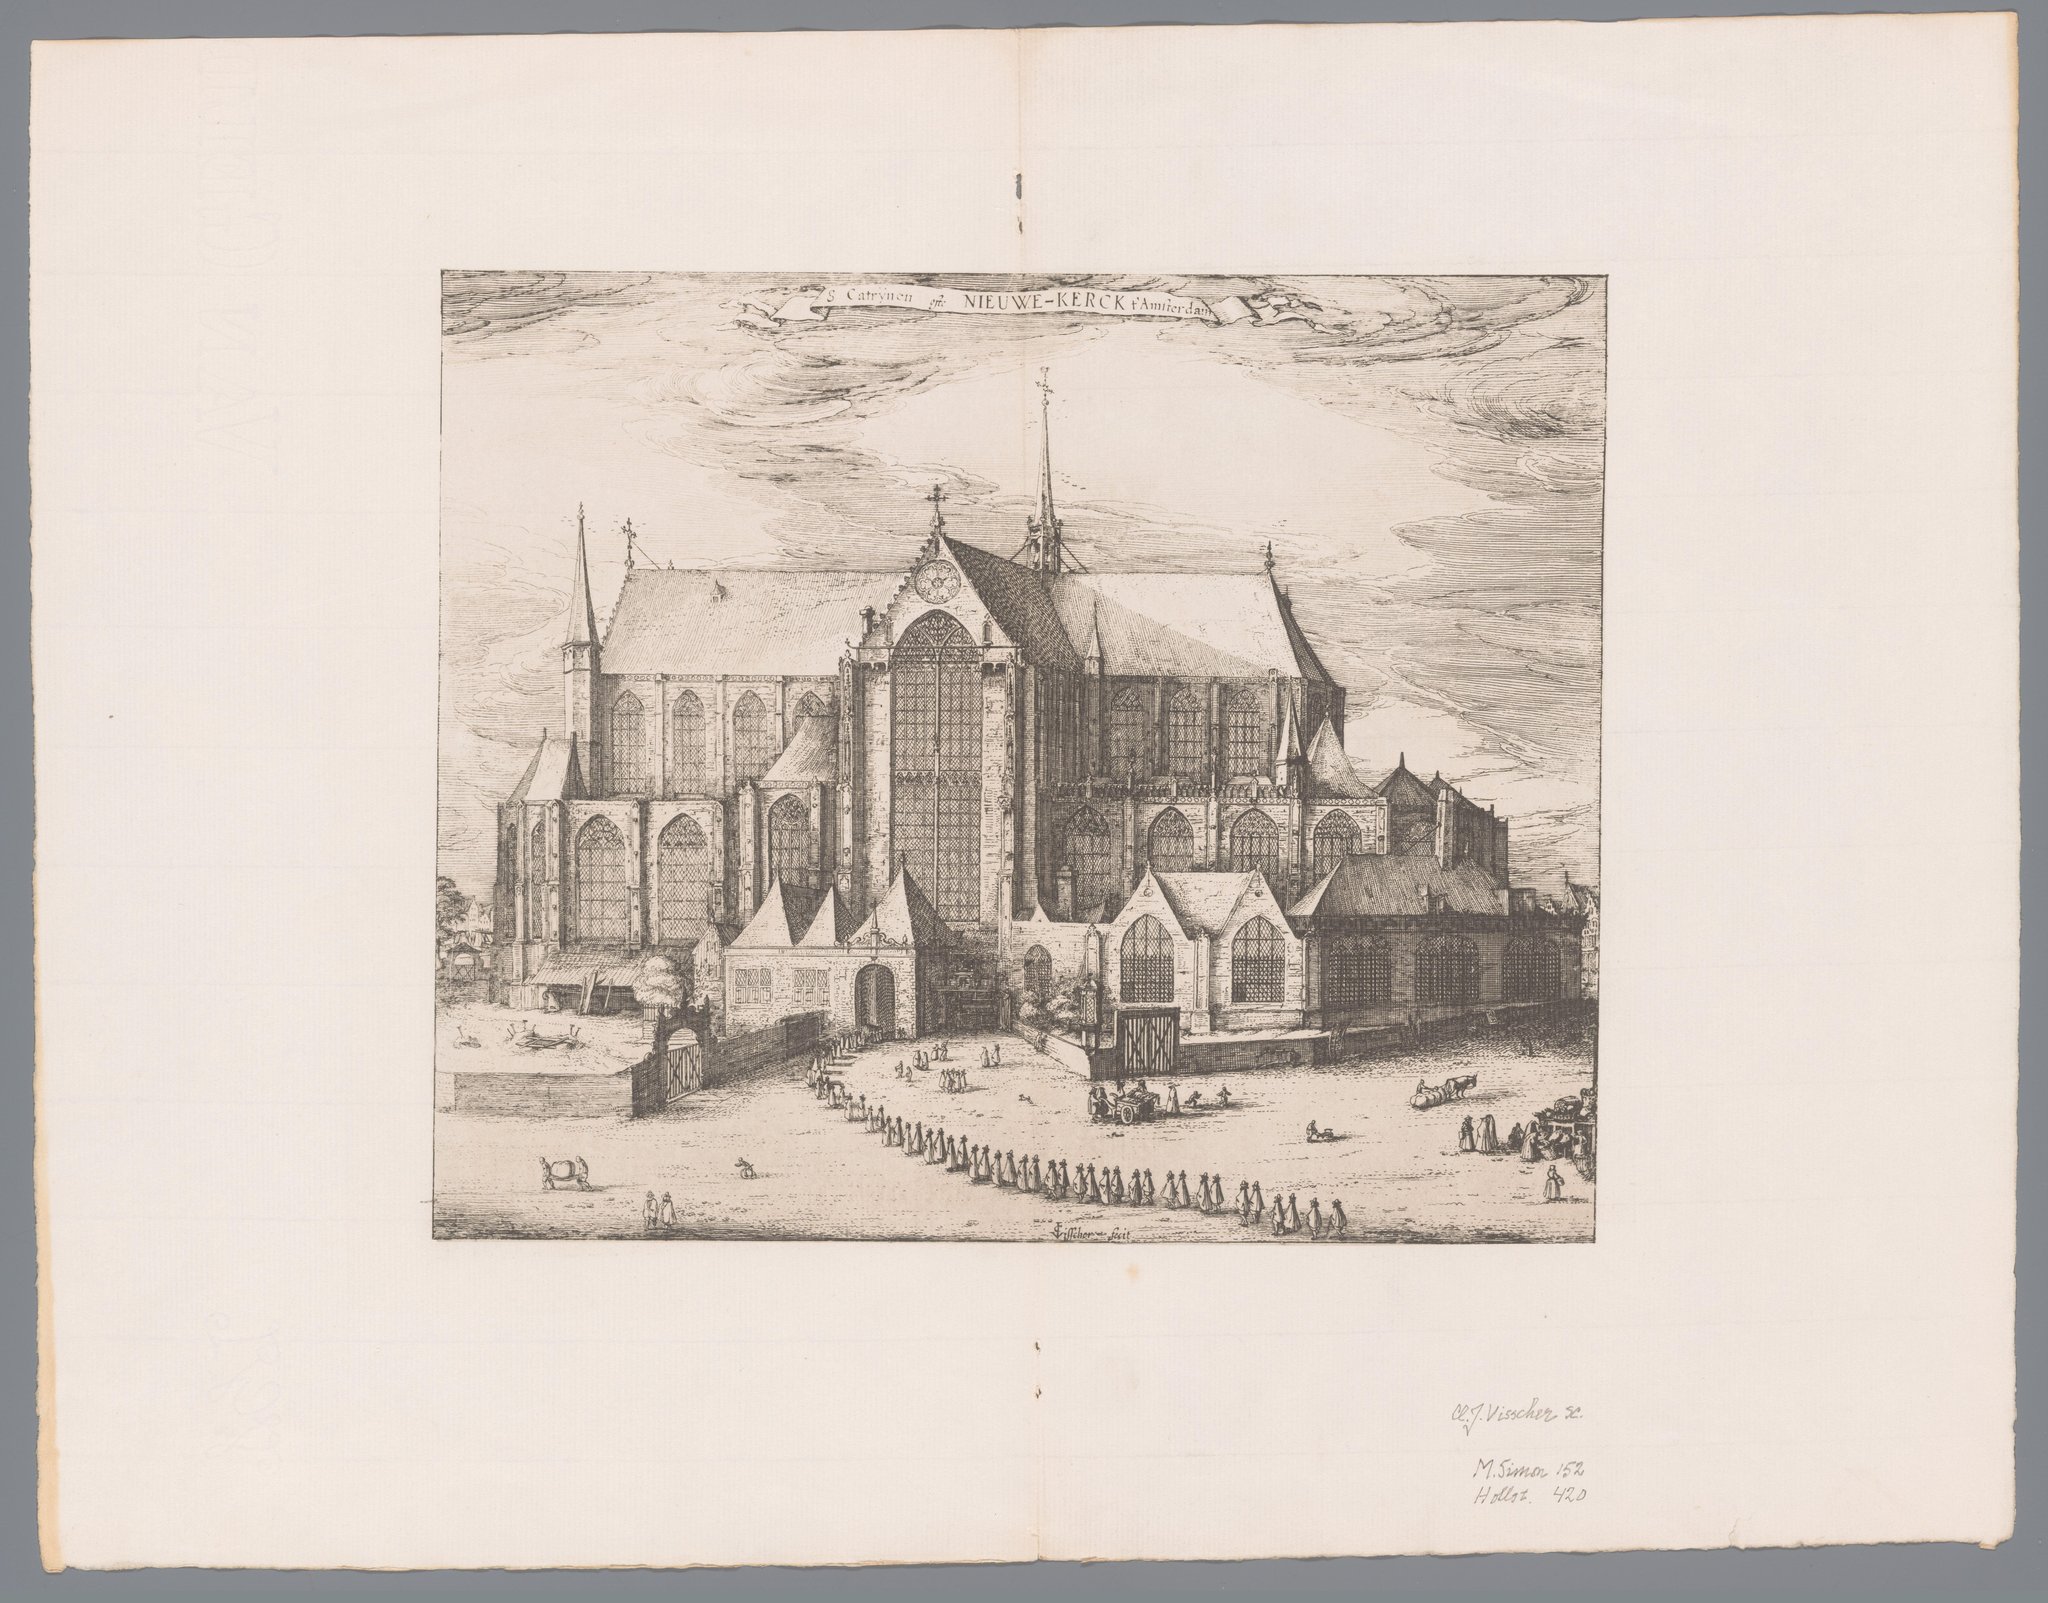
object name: book illustration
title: De Nieuwe Kerk, van achteren Ao. 1544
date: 1729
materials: paper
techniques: etching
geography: amsterdam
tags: church (exterior)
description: Prent uit: Long, Isaac le. Historische beschryvinge van de reformatie der stadt Amsterdam (…). Amsterdam: Johannes van Septeren (I), 1729, tussen p. 288 en 289.